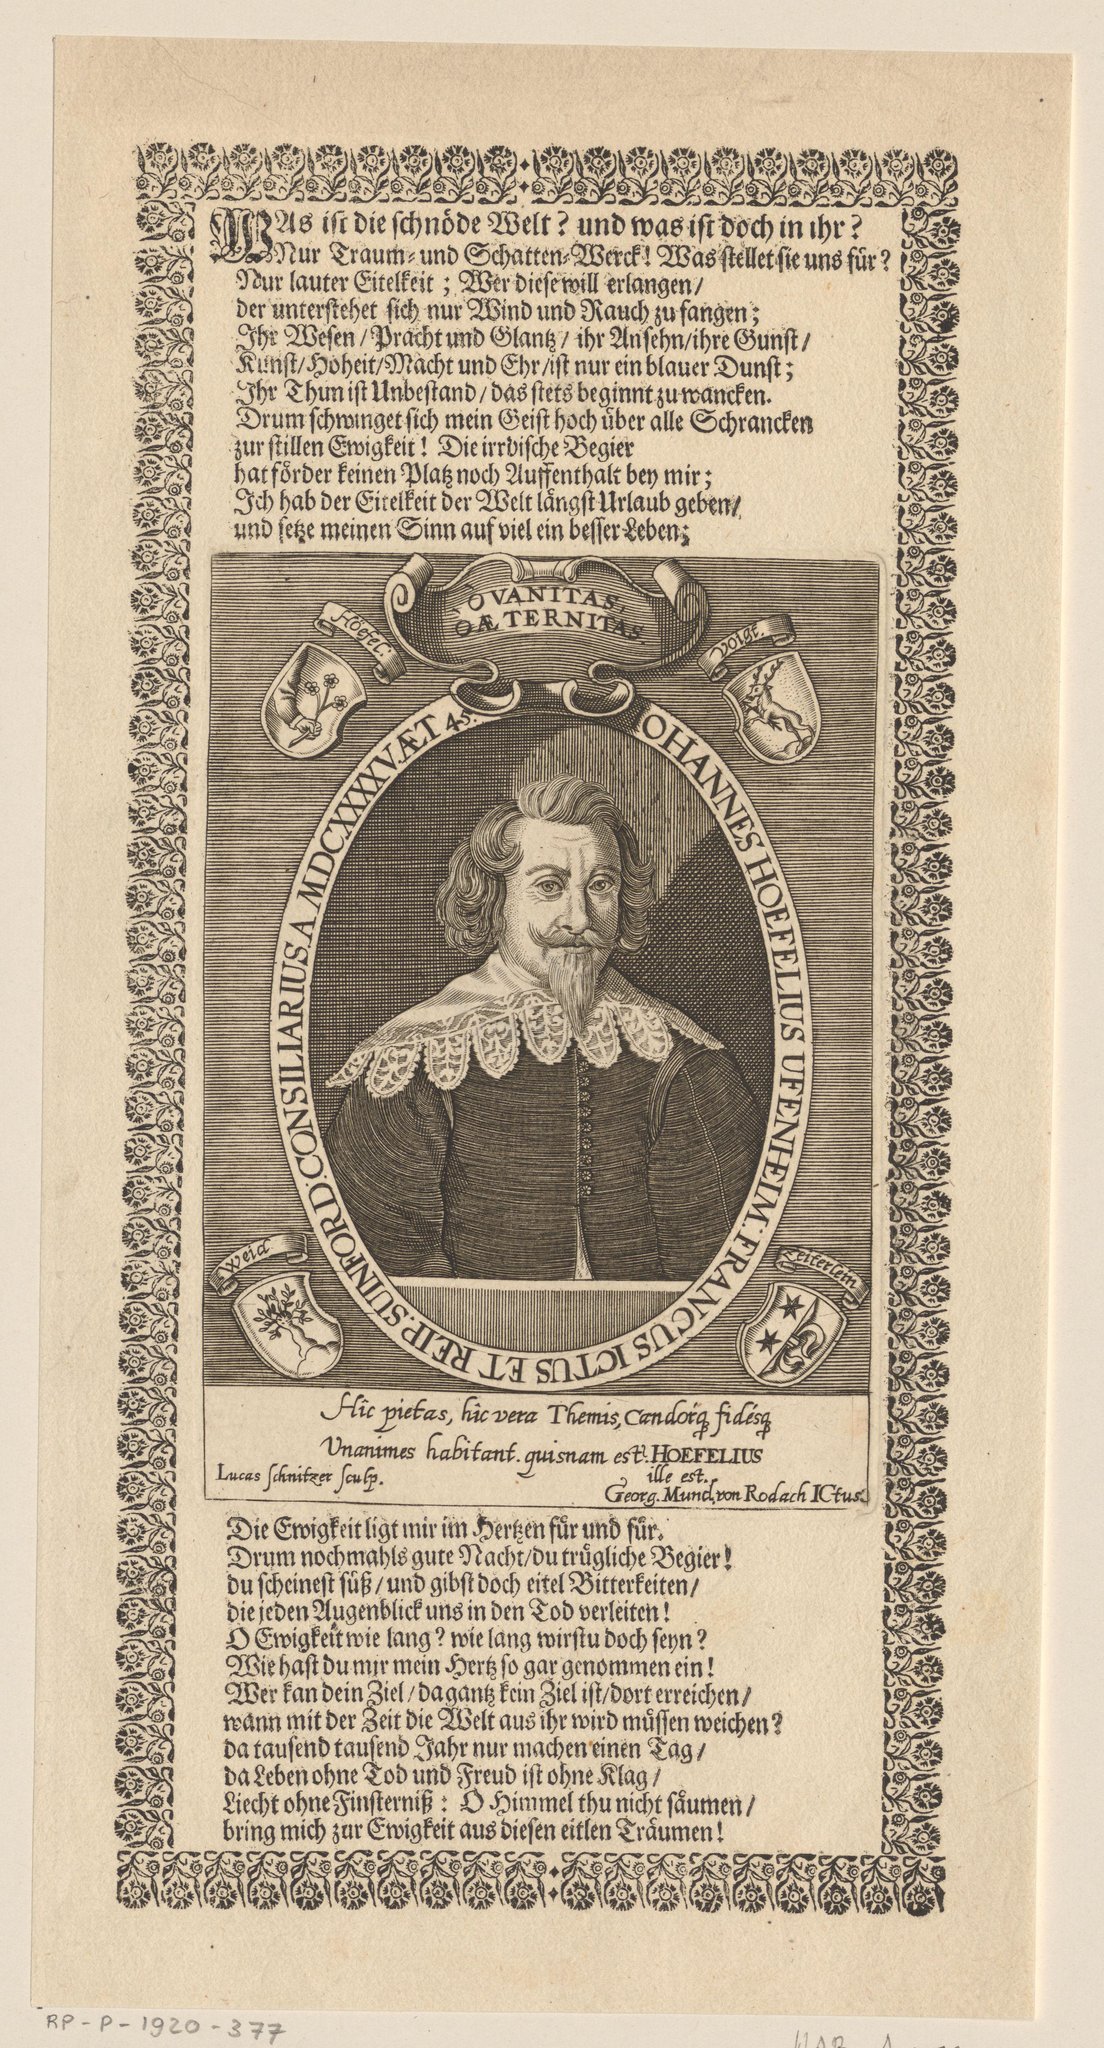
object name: print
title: Portret van Johann Höfel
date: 1645-1674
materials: paper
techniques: engraving, letterpress printing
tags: historical persons, armorial bearing, heraldry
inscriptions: collector's mark: Lugt 2228